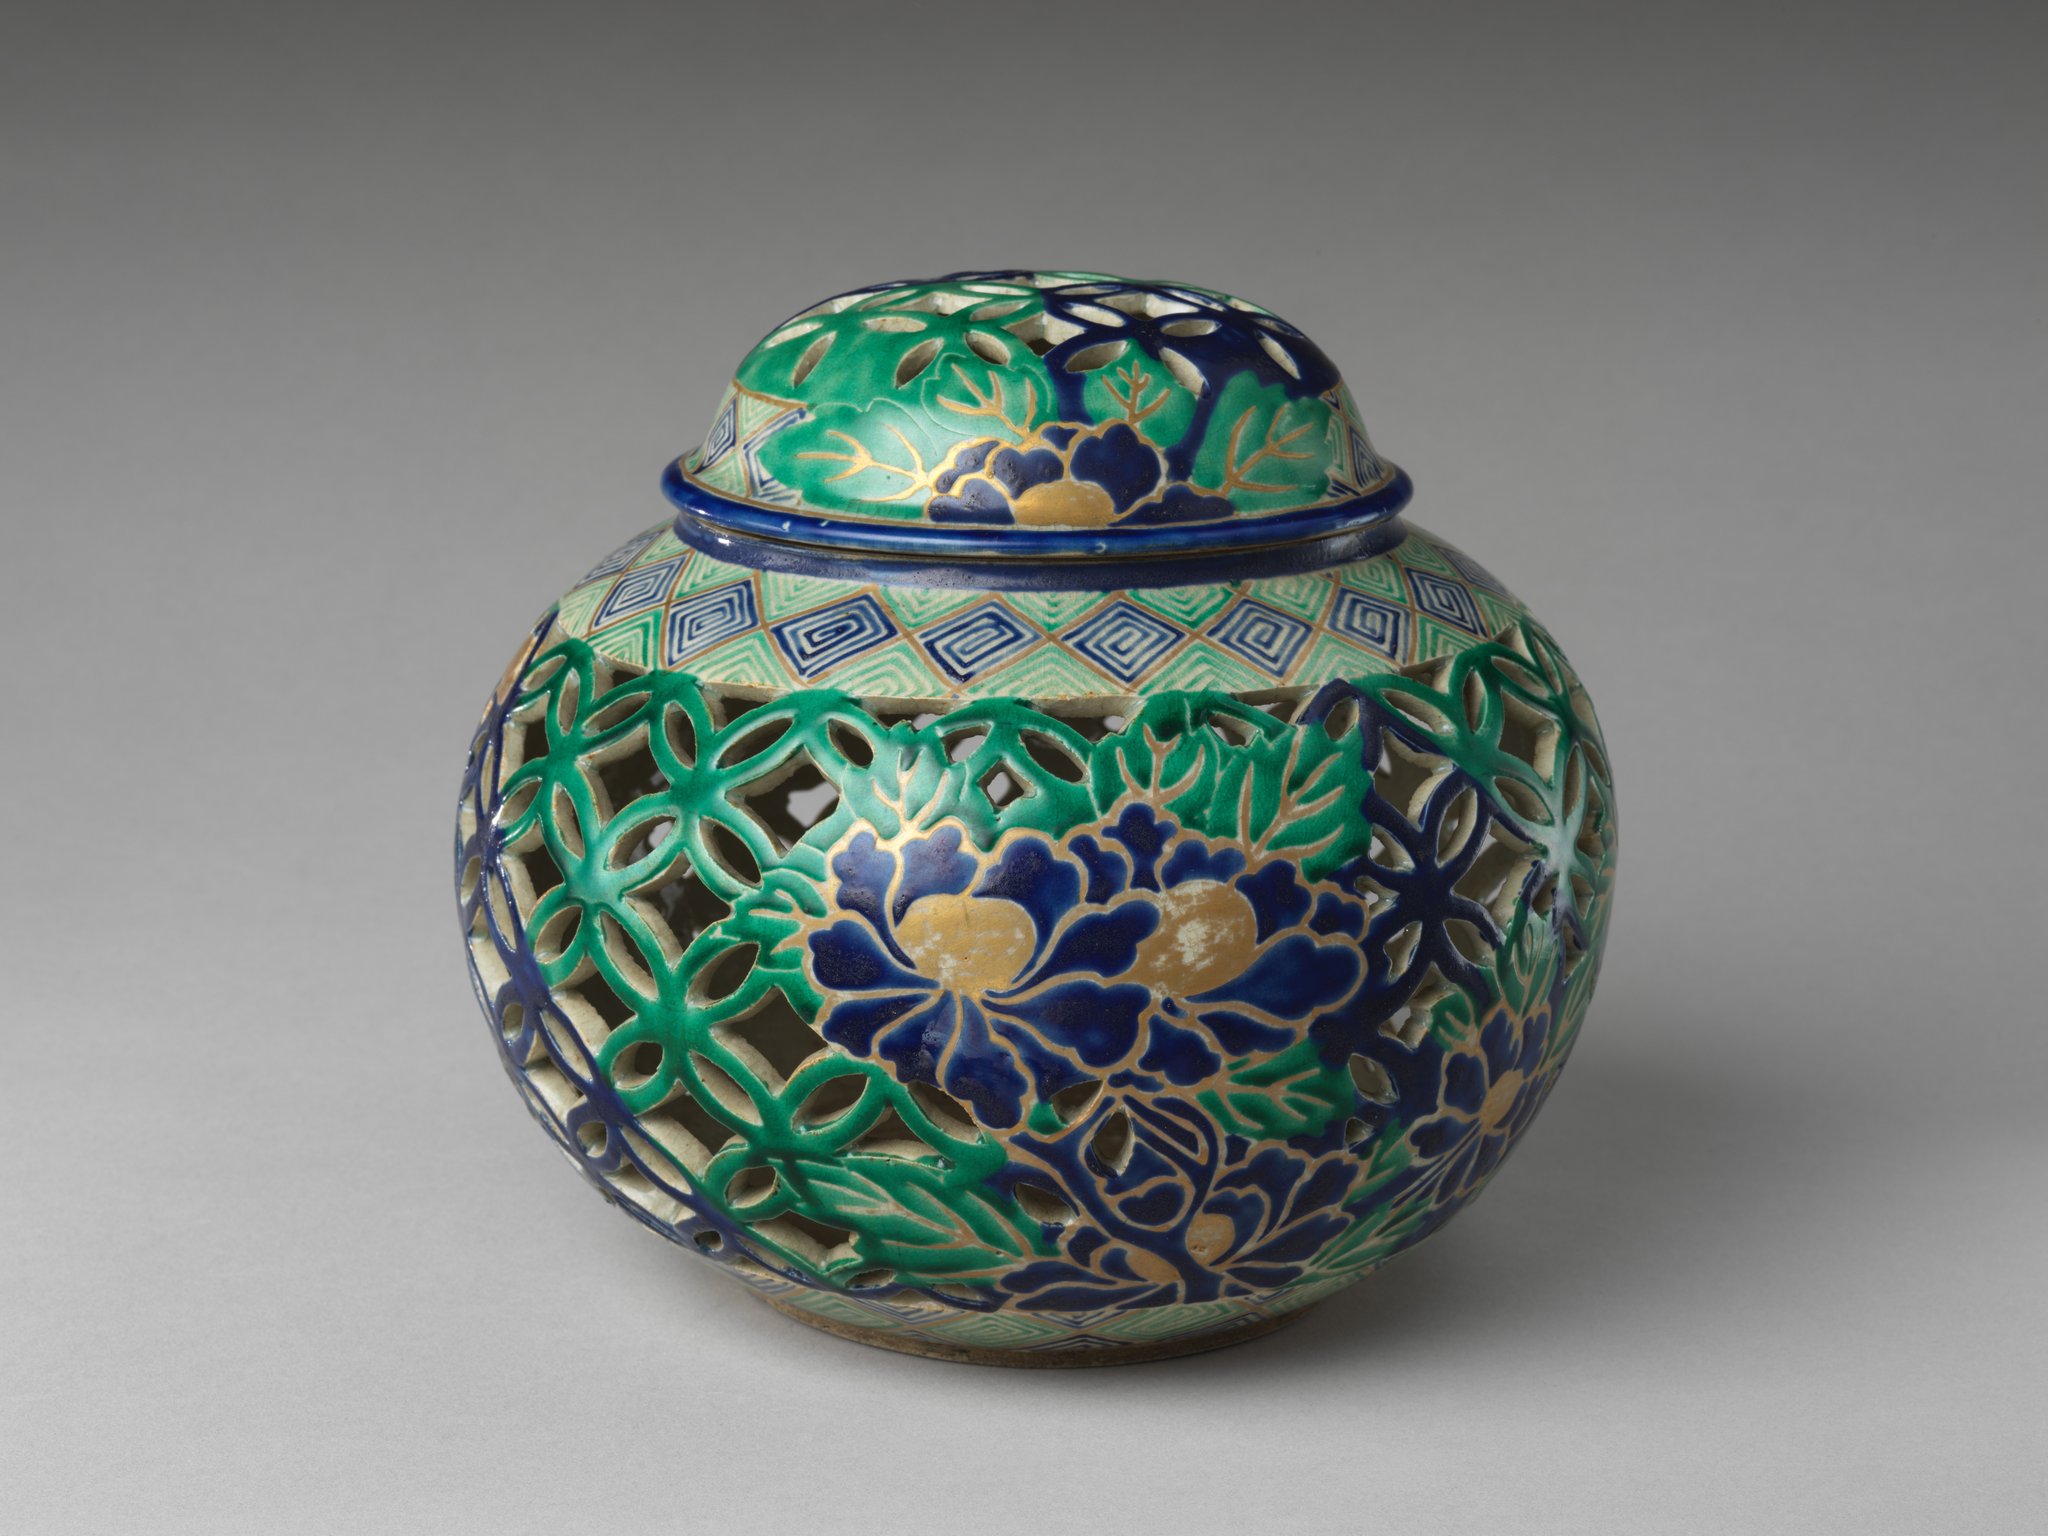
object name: incense burner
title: Incense burner with pierced design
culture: japanese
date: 1667-1733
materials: enamel, stoneware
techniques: overglaze